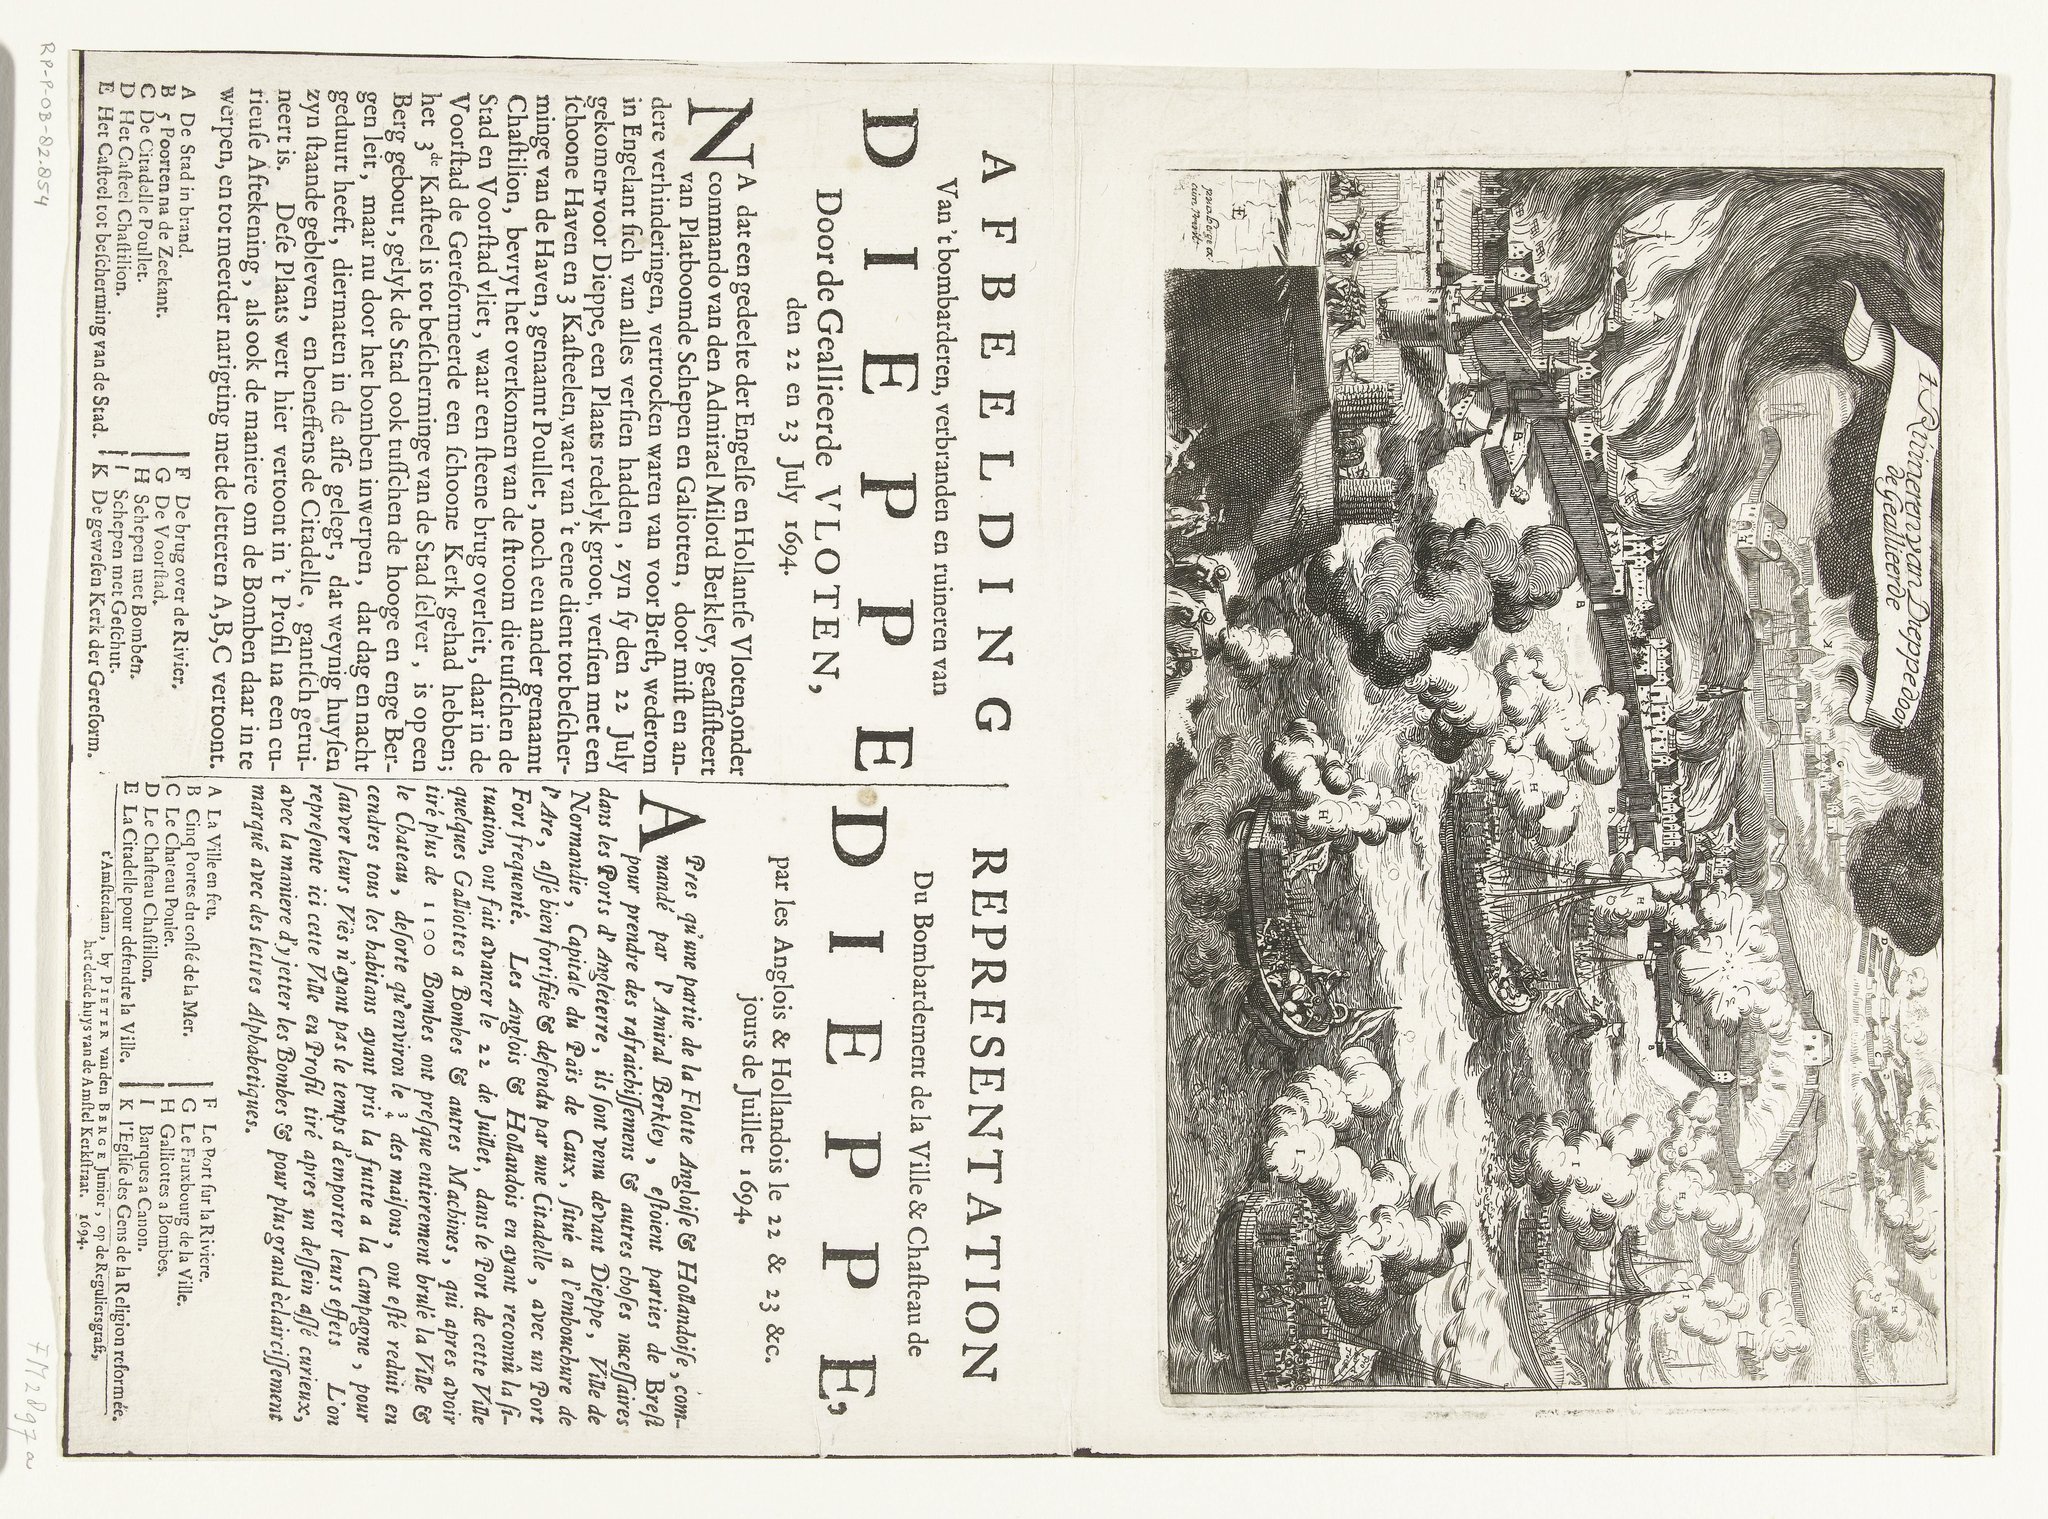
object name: print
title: Representation Du Bombardement de la Ville & Chasteau de Dieppe, par les Anglois & Hollandois le 22 & 23 &c. jours de Juillet 1694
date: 1694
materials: paper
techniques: engraving, etching, letterpress printing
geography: amsterdam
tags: bombardment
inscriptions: date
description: Bombardement van de Franse havenplaats Dieppe door de gecombineerde Engelse en Hollandse vloot, 22-23 juli 1694. De stad staat in brand. Op het blad onder de plaat gedrukt in 2 kolommen de beschrijvingen van de gebeurtenissen en de legenda's A-K in het Nederlands en Frans.